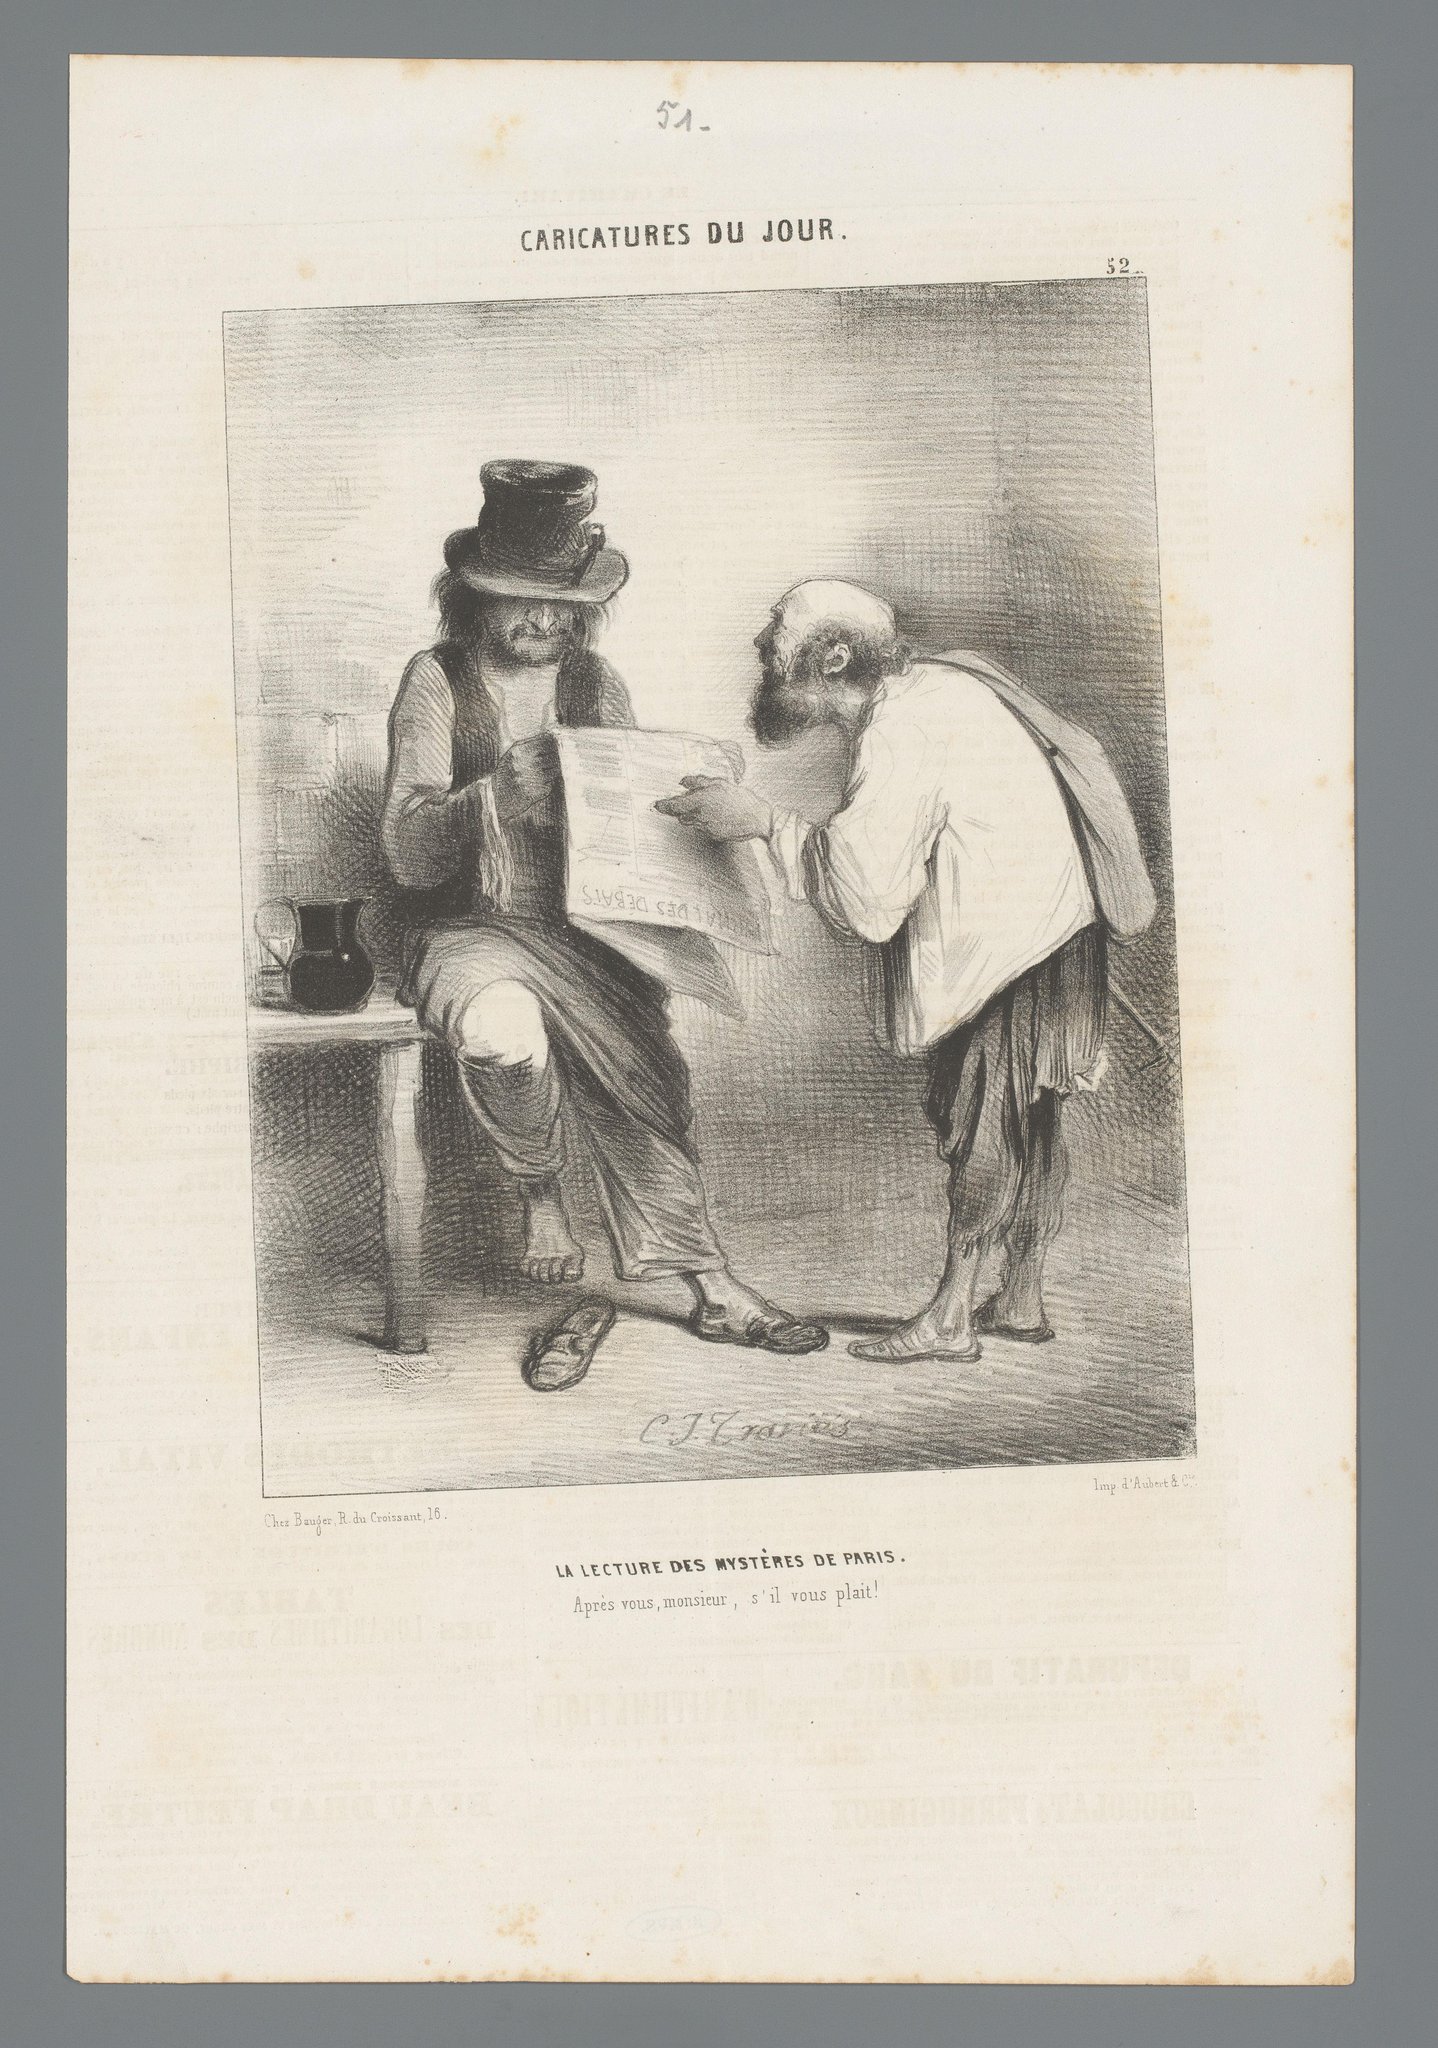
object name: print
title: Caricatures du jour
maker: charles-joseph traviès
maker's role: print maker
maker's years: 1804-1859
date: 1843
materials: paper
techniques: letterpress printing, lithograph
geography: paris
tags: press, journalism, adult man ( + one person), beggar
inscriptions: collector's mark: Lugt 2228